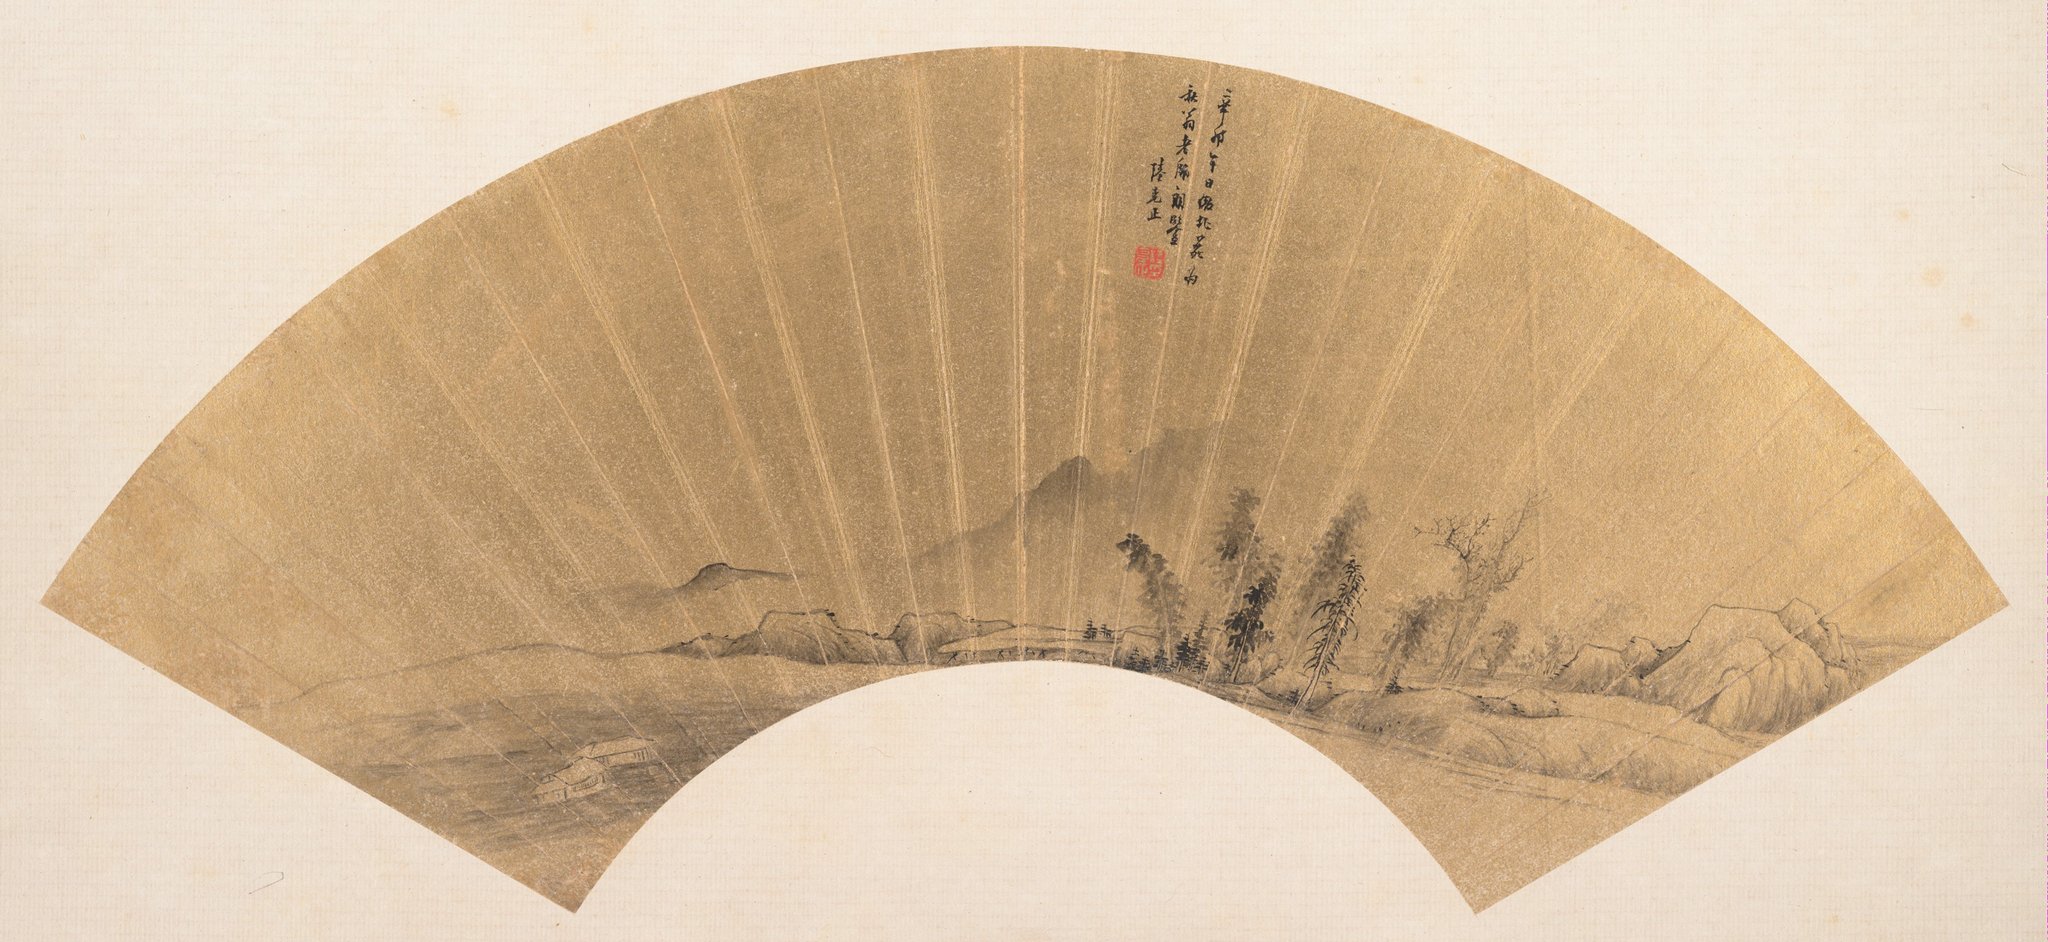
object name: folding fan mounted a an album leaf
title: Landscape in the manner of Dong Yuan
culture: chinese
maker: lu kezheng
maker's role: artist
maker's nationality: chinese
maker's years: 1600-1644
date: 1591-1651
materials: gold, ink, paper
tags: landscapes